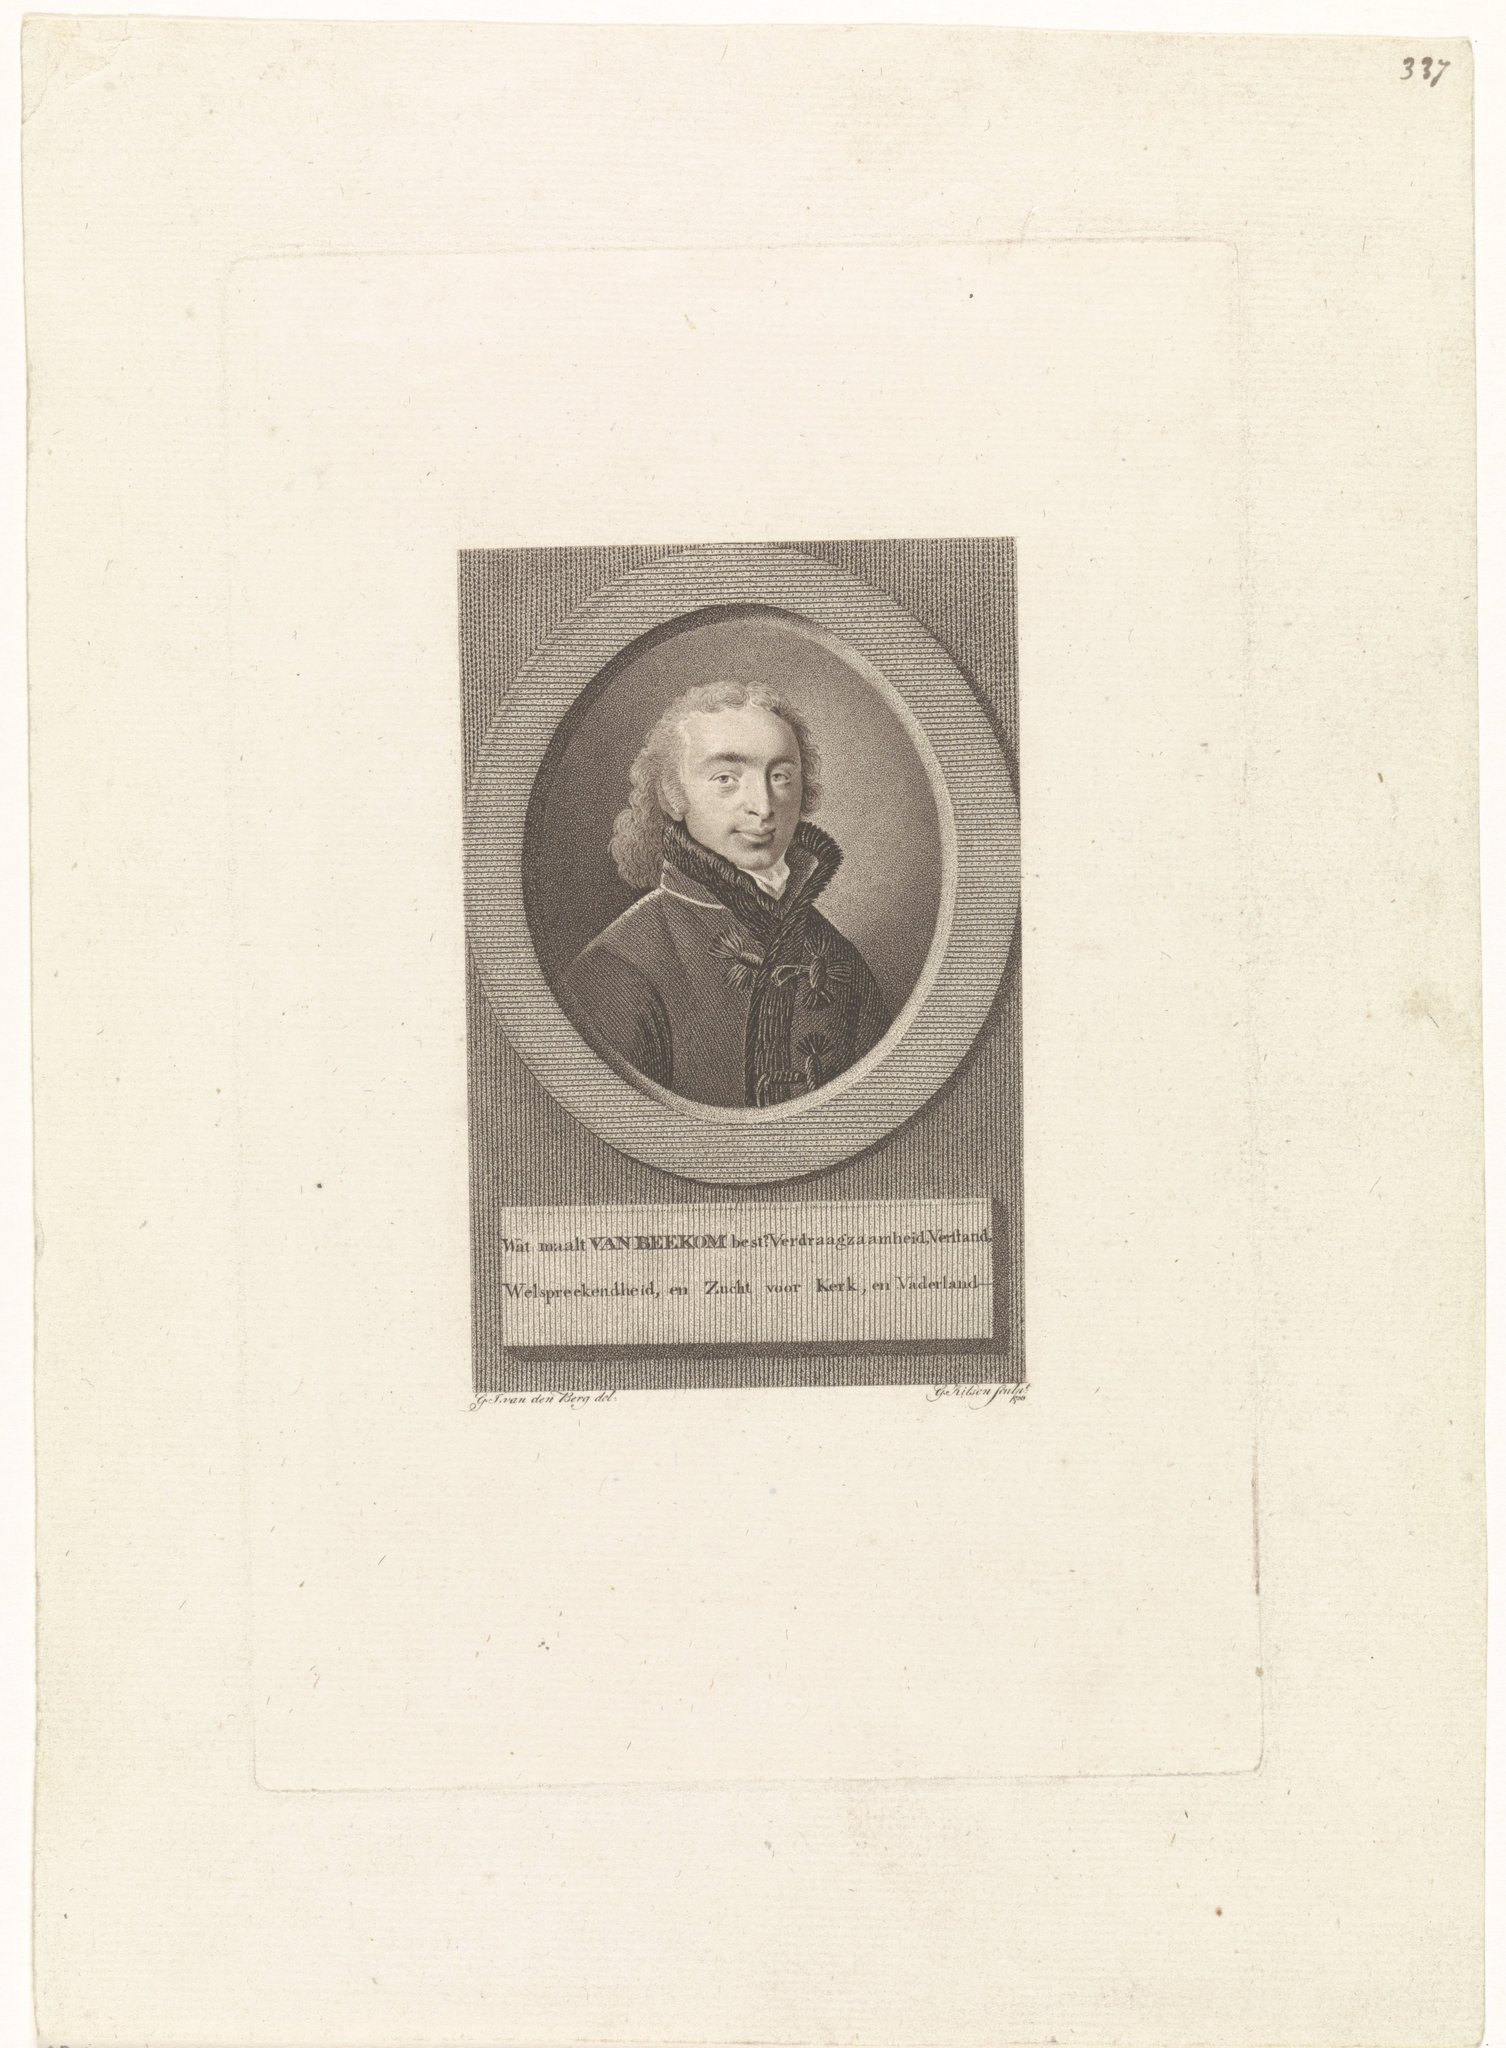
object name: print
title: Portret van Van Beekom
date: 1776-1810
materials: paper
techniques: aquatint, engraving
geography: rotterdam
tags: wig (+ sideview, profile)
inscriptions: collector's mark: Lugt 2228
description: Portretbuste van Van Beekom. Onder de ovale omlijsting een tweeregelige Nederlandse tekst.